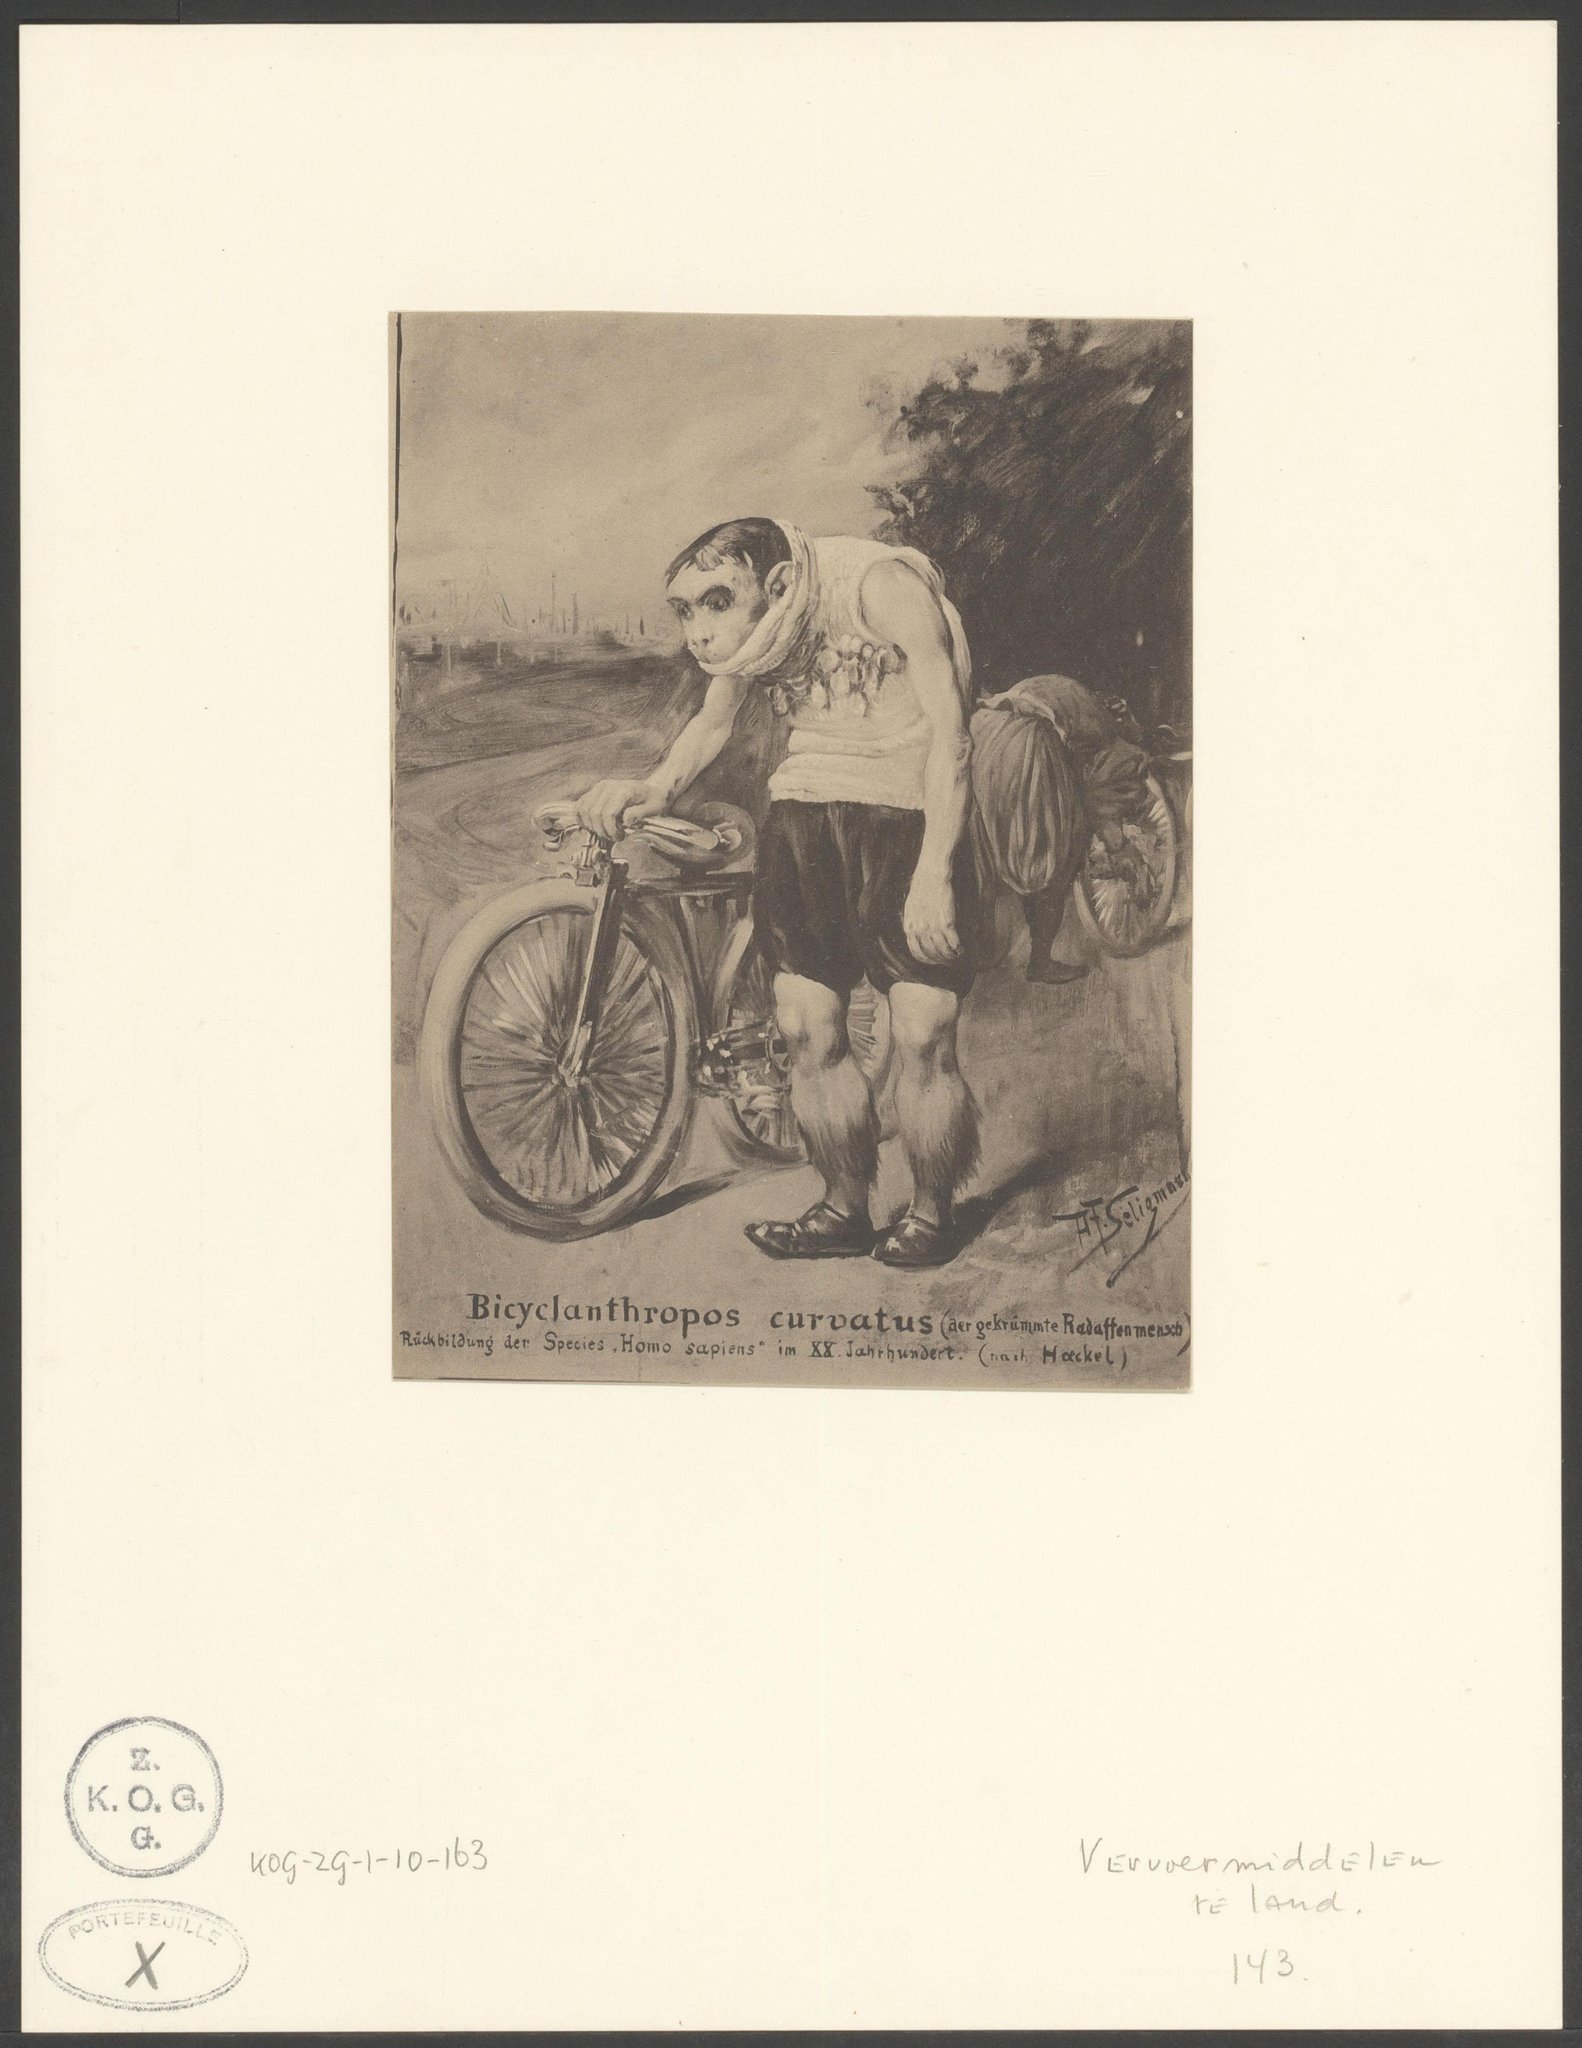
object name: photomechanical print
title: Aap naast een fiets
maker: Anonymous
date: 1875-1930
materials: paper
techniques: photograph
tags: monkeys, apes, caricatures (human types), bicycle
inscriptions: collector's mark: Lugt 1641, stamp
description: Een aap met een broek en hemd aan, staat naast een fiets. Onderwerpsrubrieken binnen de Atlas Zeden en Gewoonten: Handel, Nijverheid en Verkeer, Vervoermiddelen te land, Draisine en rijwiel.